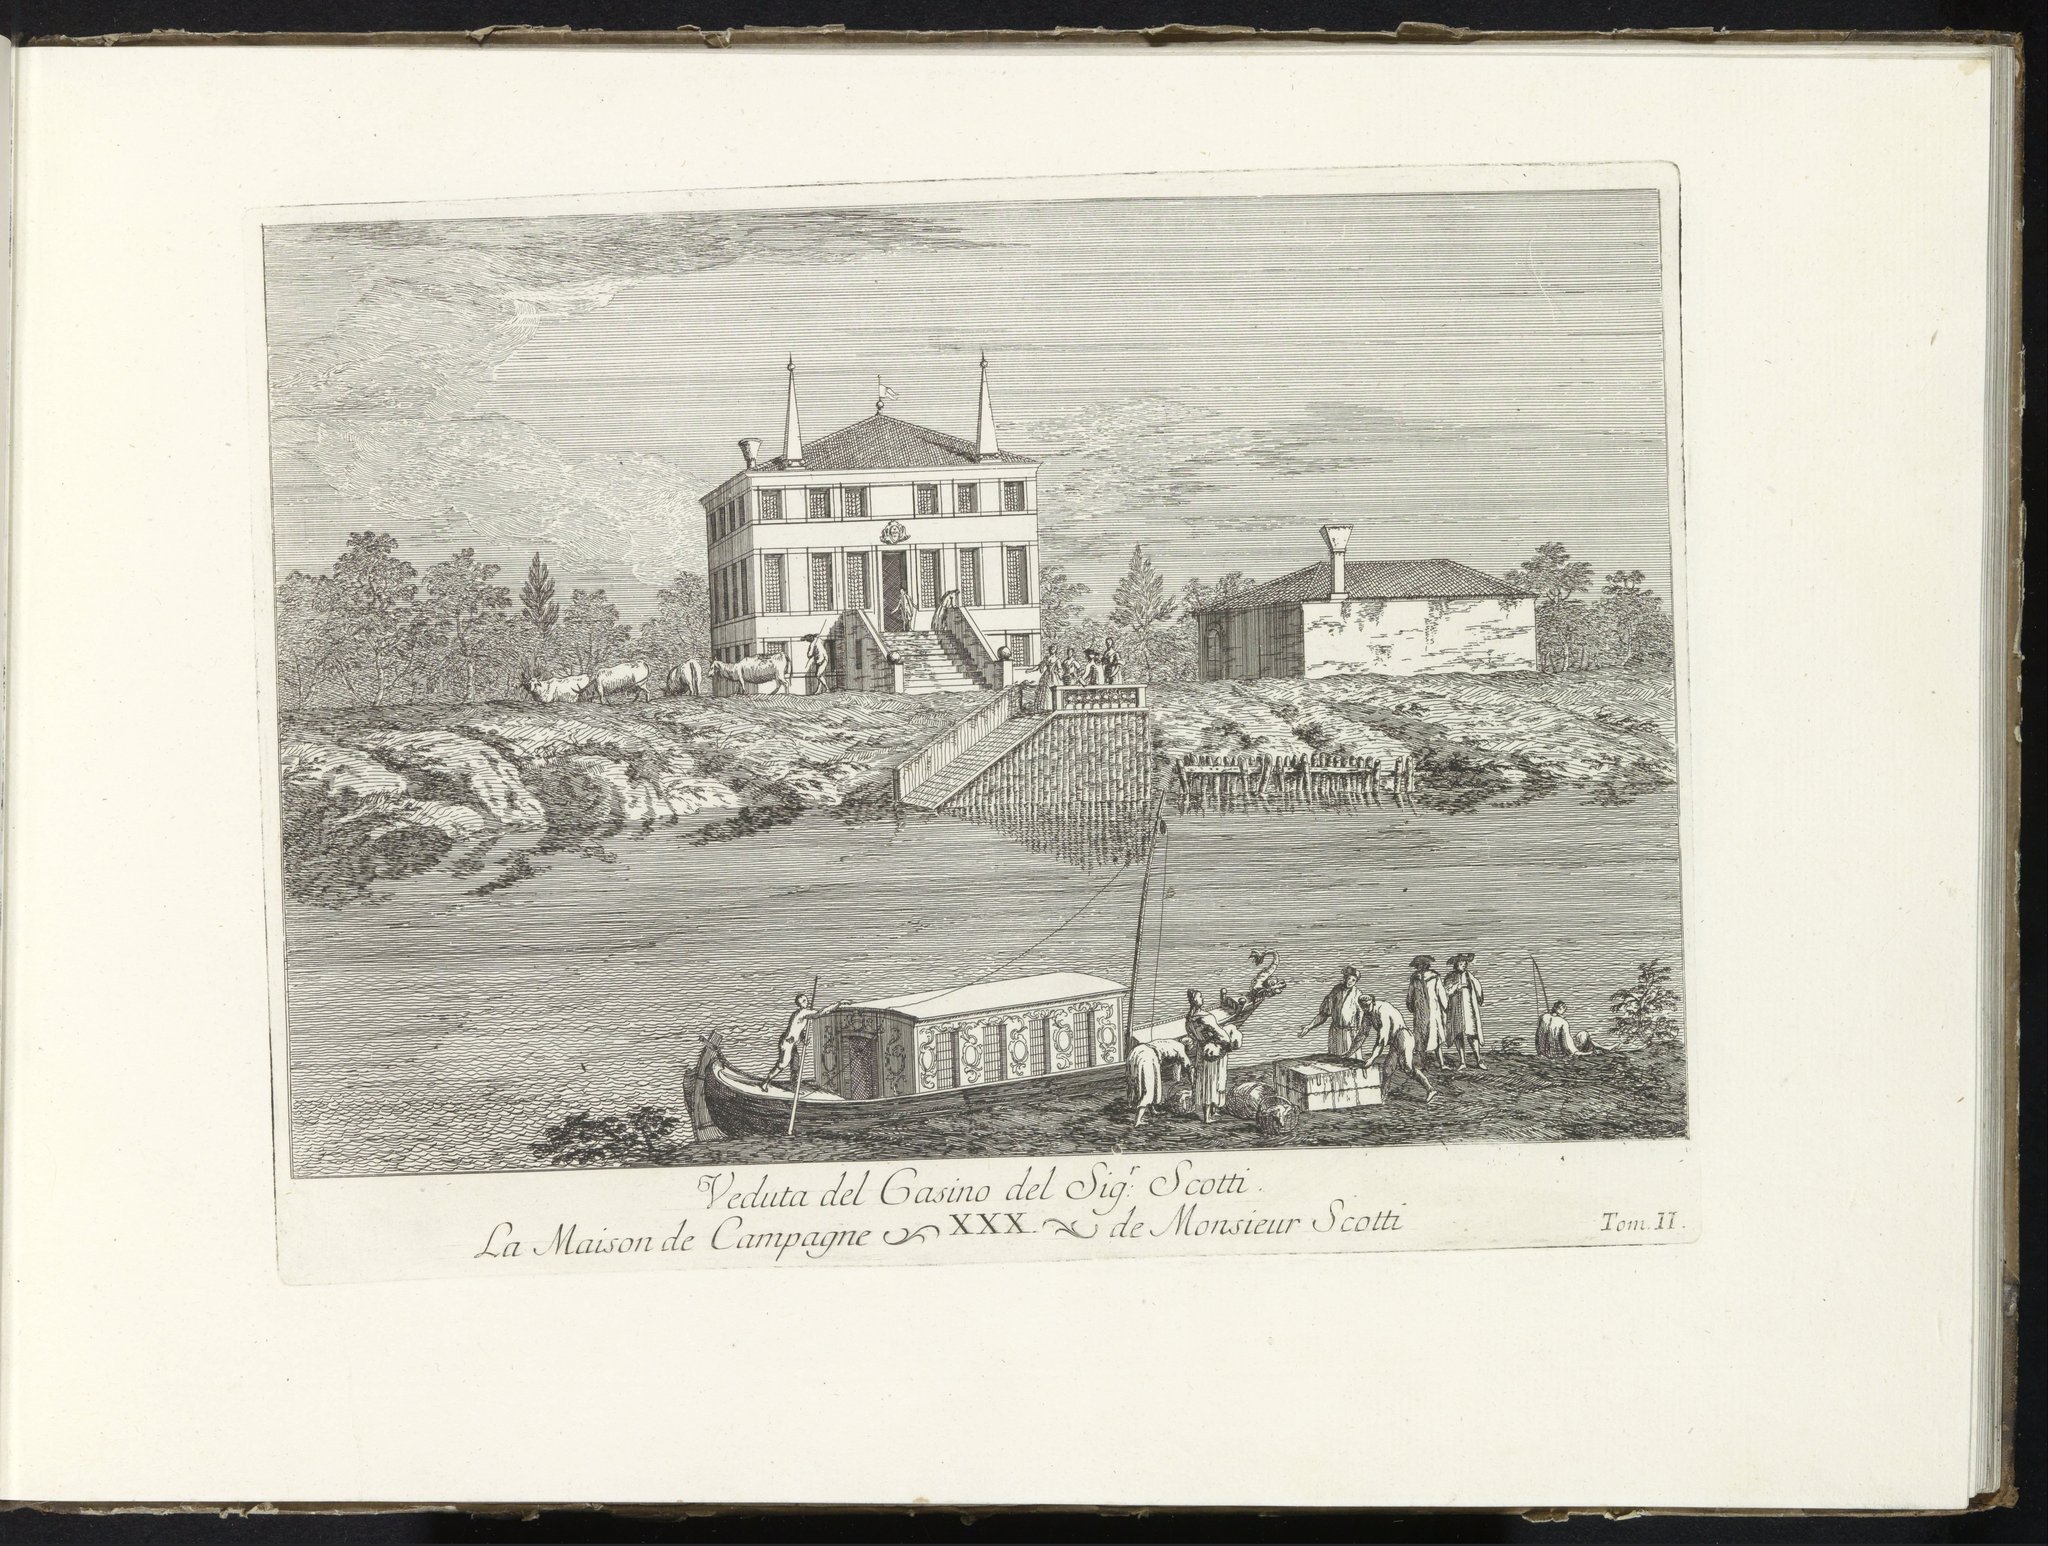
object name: print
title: Gezichten op de rivier de Brenta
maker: giovanni francesco costa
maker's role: draughtsman, painter, print maker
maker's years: -1773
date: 1750-1760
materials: paper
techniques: etching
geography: italy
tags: river, hôtel, i.e. small palace in city, gondola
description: Gezicht op Casino del Signore Scotti aan de rivier de Brenta. Op de voorgrond ligt een aangemeerde gondel. Genummerd midden onder: XXX en rechtsonder: Tom: II. Deze prent maakt deel uit van een album.